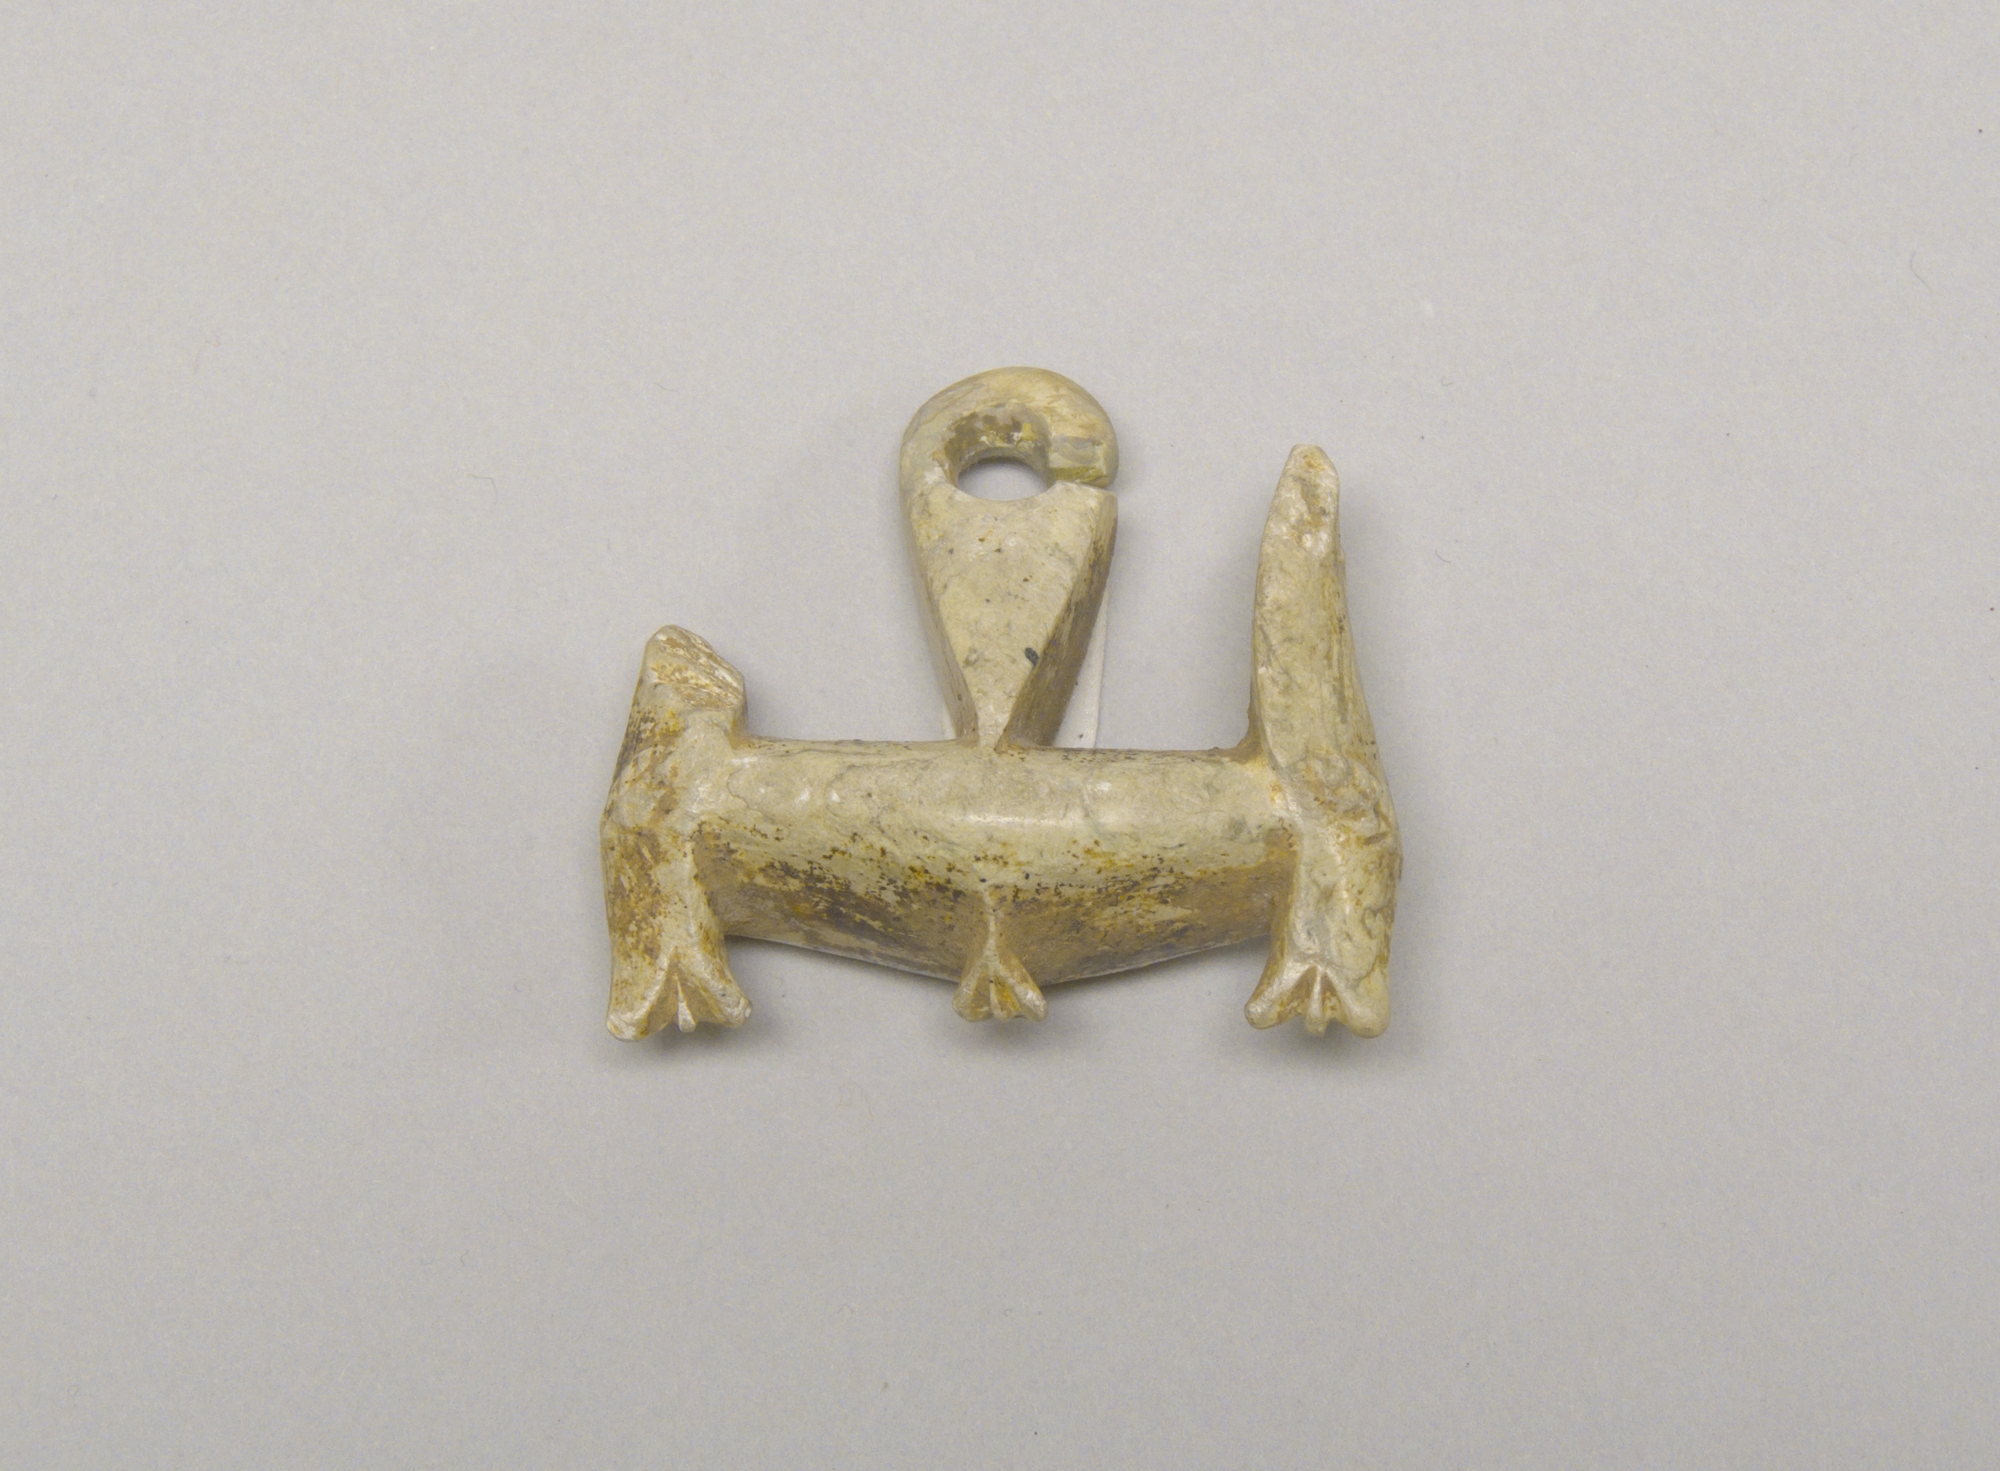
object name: earring with pendant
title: Ear pendant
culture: vietnamese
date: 500 BCE-300 CE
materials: stone